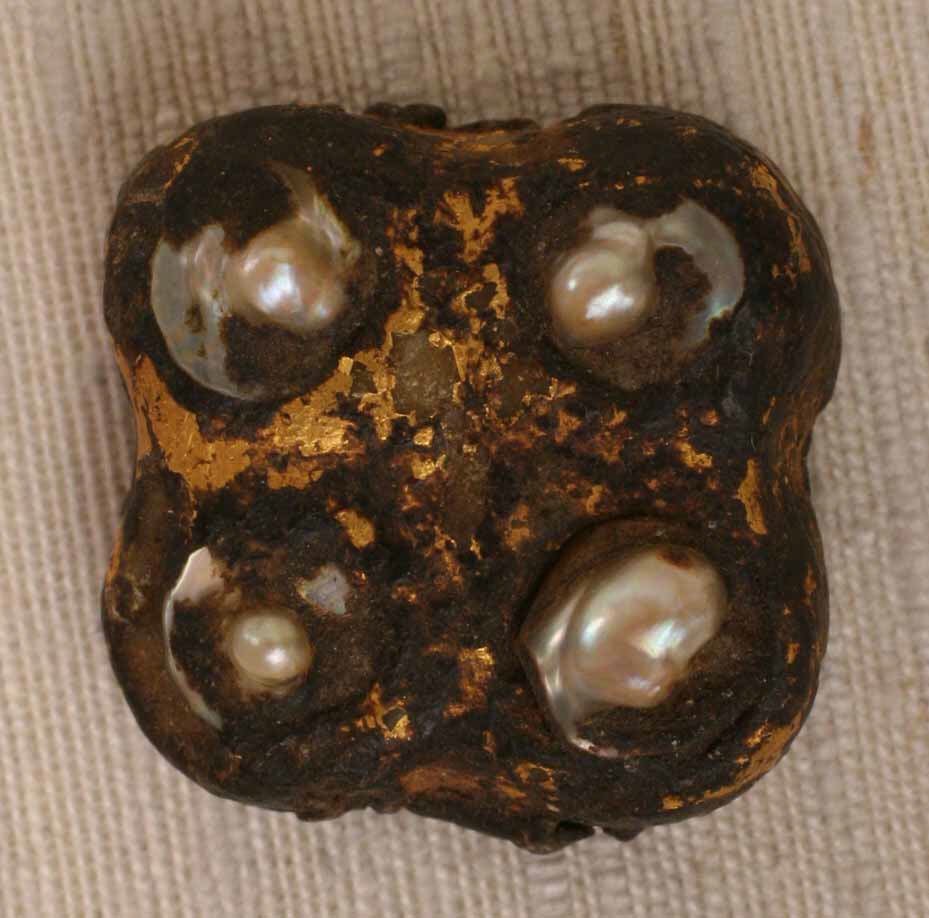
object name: plaque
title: Plaque for a Collar or Necklace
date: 701-800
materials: gold, mother of pearl, stone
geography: egypt